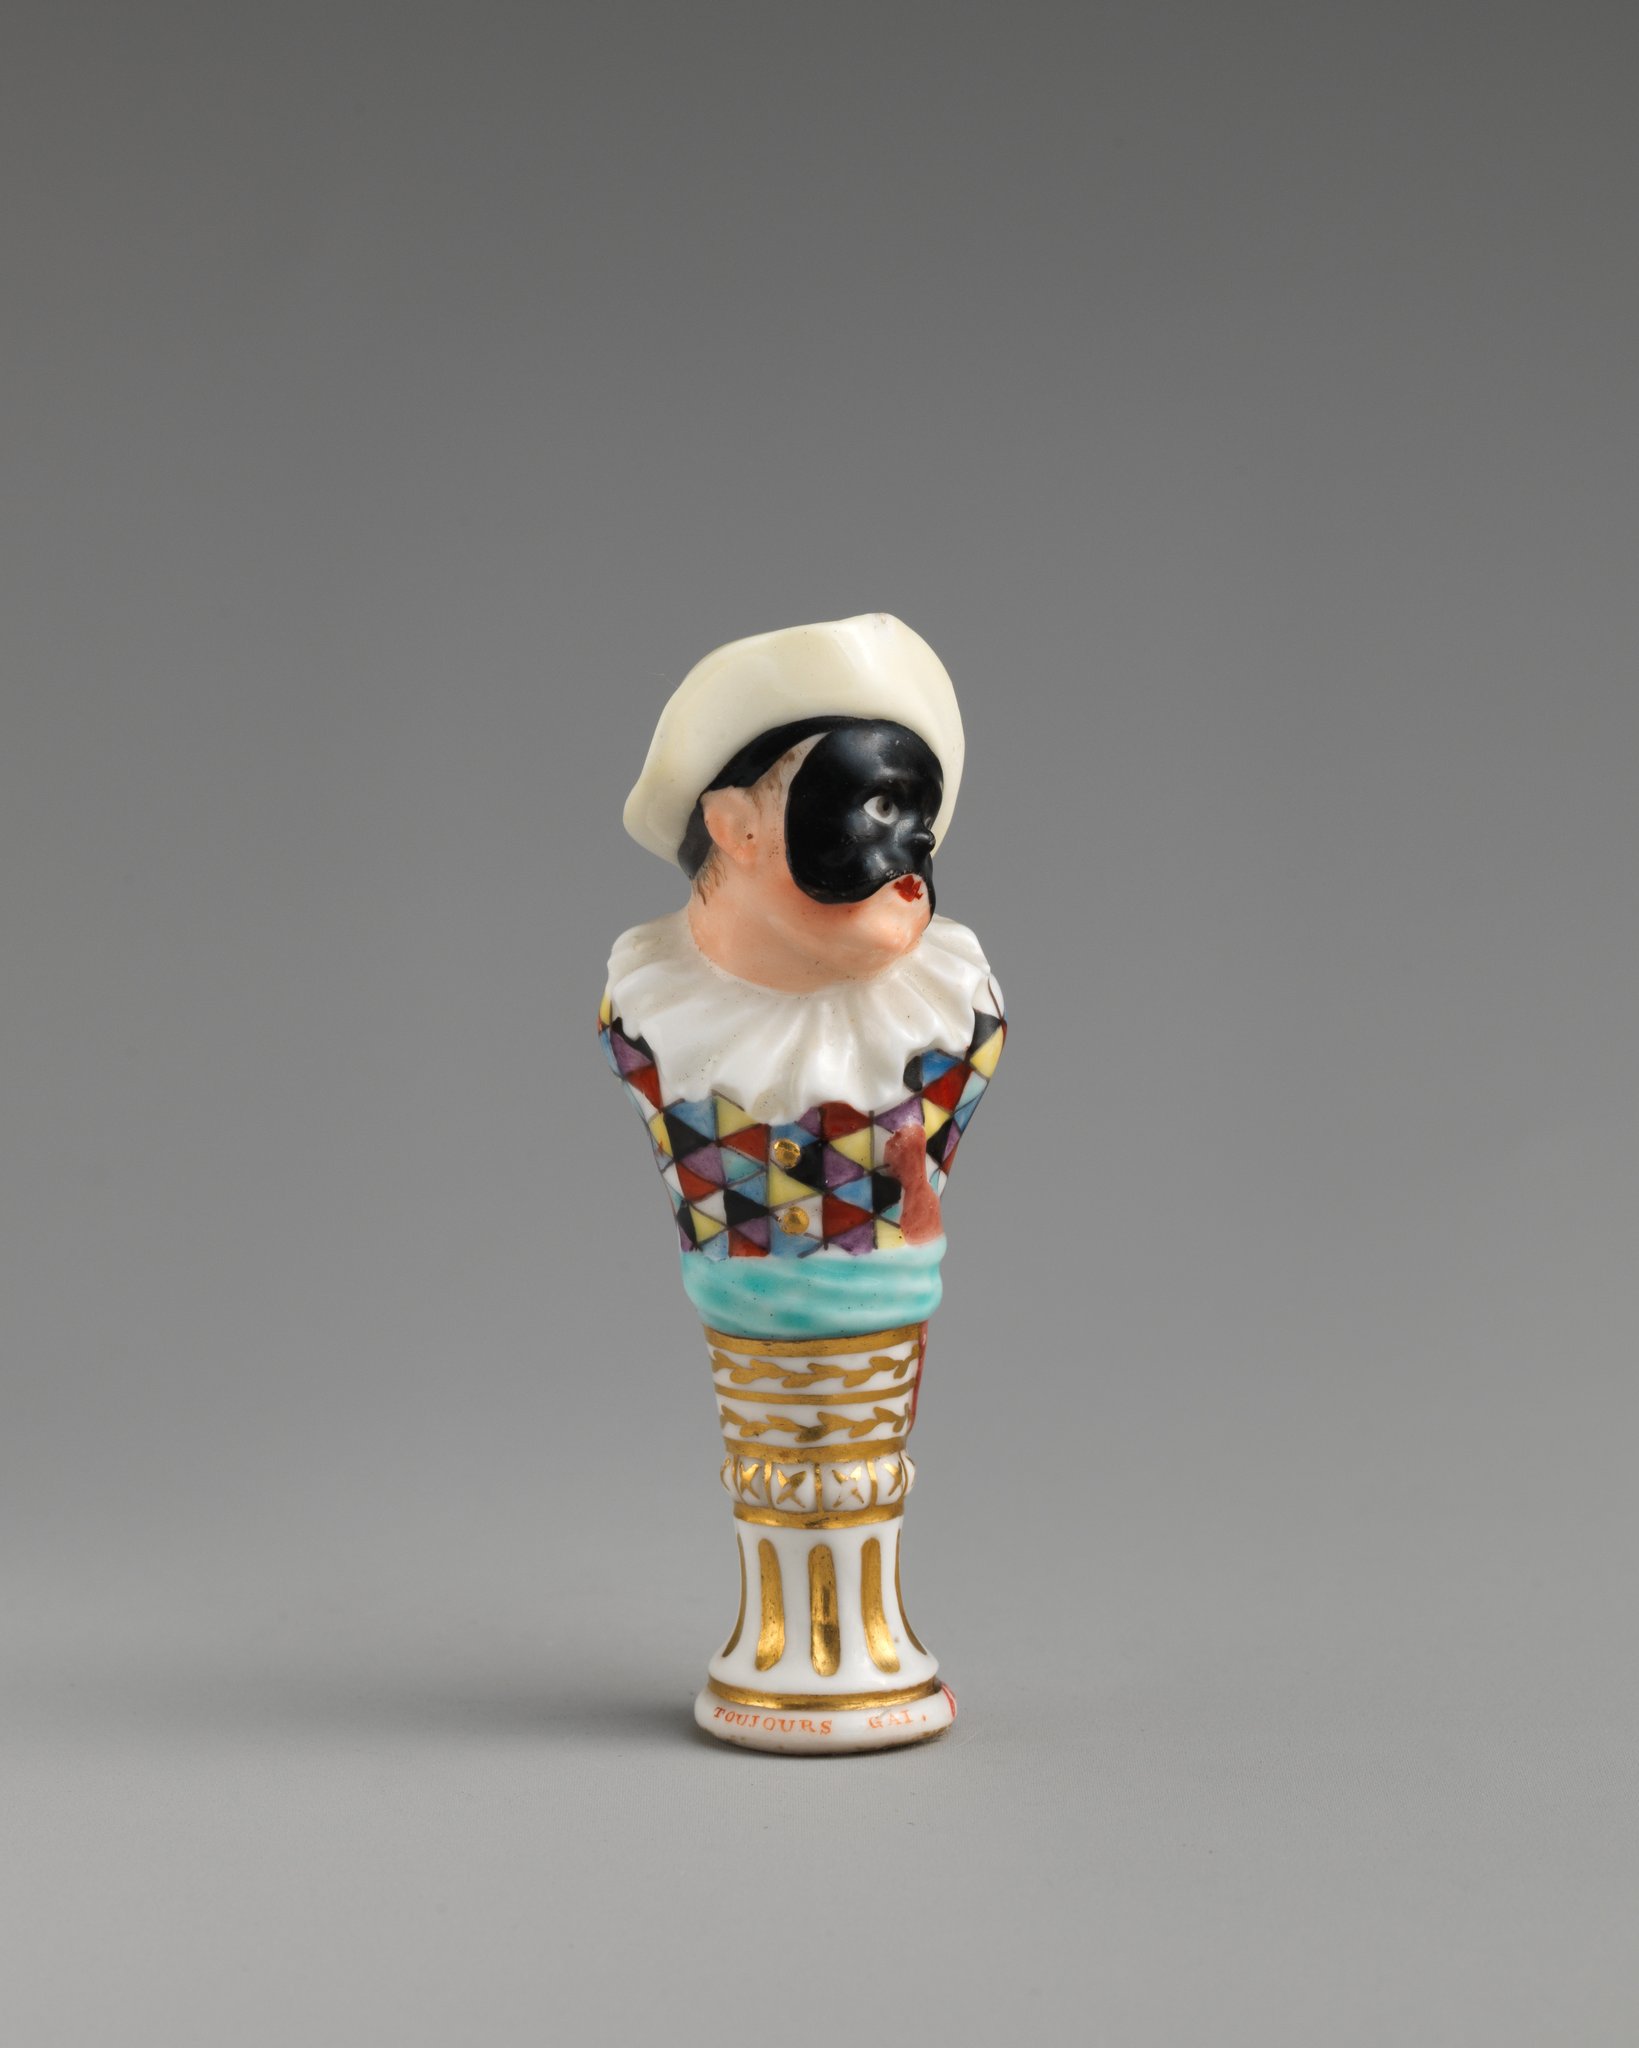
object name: toy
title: Bust of Harlequin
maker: derby porcelain manufactory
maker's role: factory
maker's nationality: british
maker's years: 1751-1785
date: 1770-1779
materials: soft paste porcelain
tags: masks,men